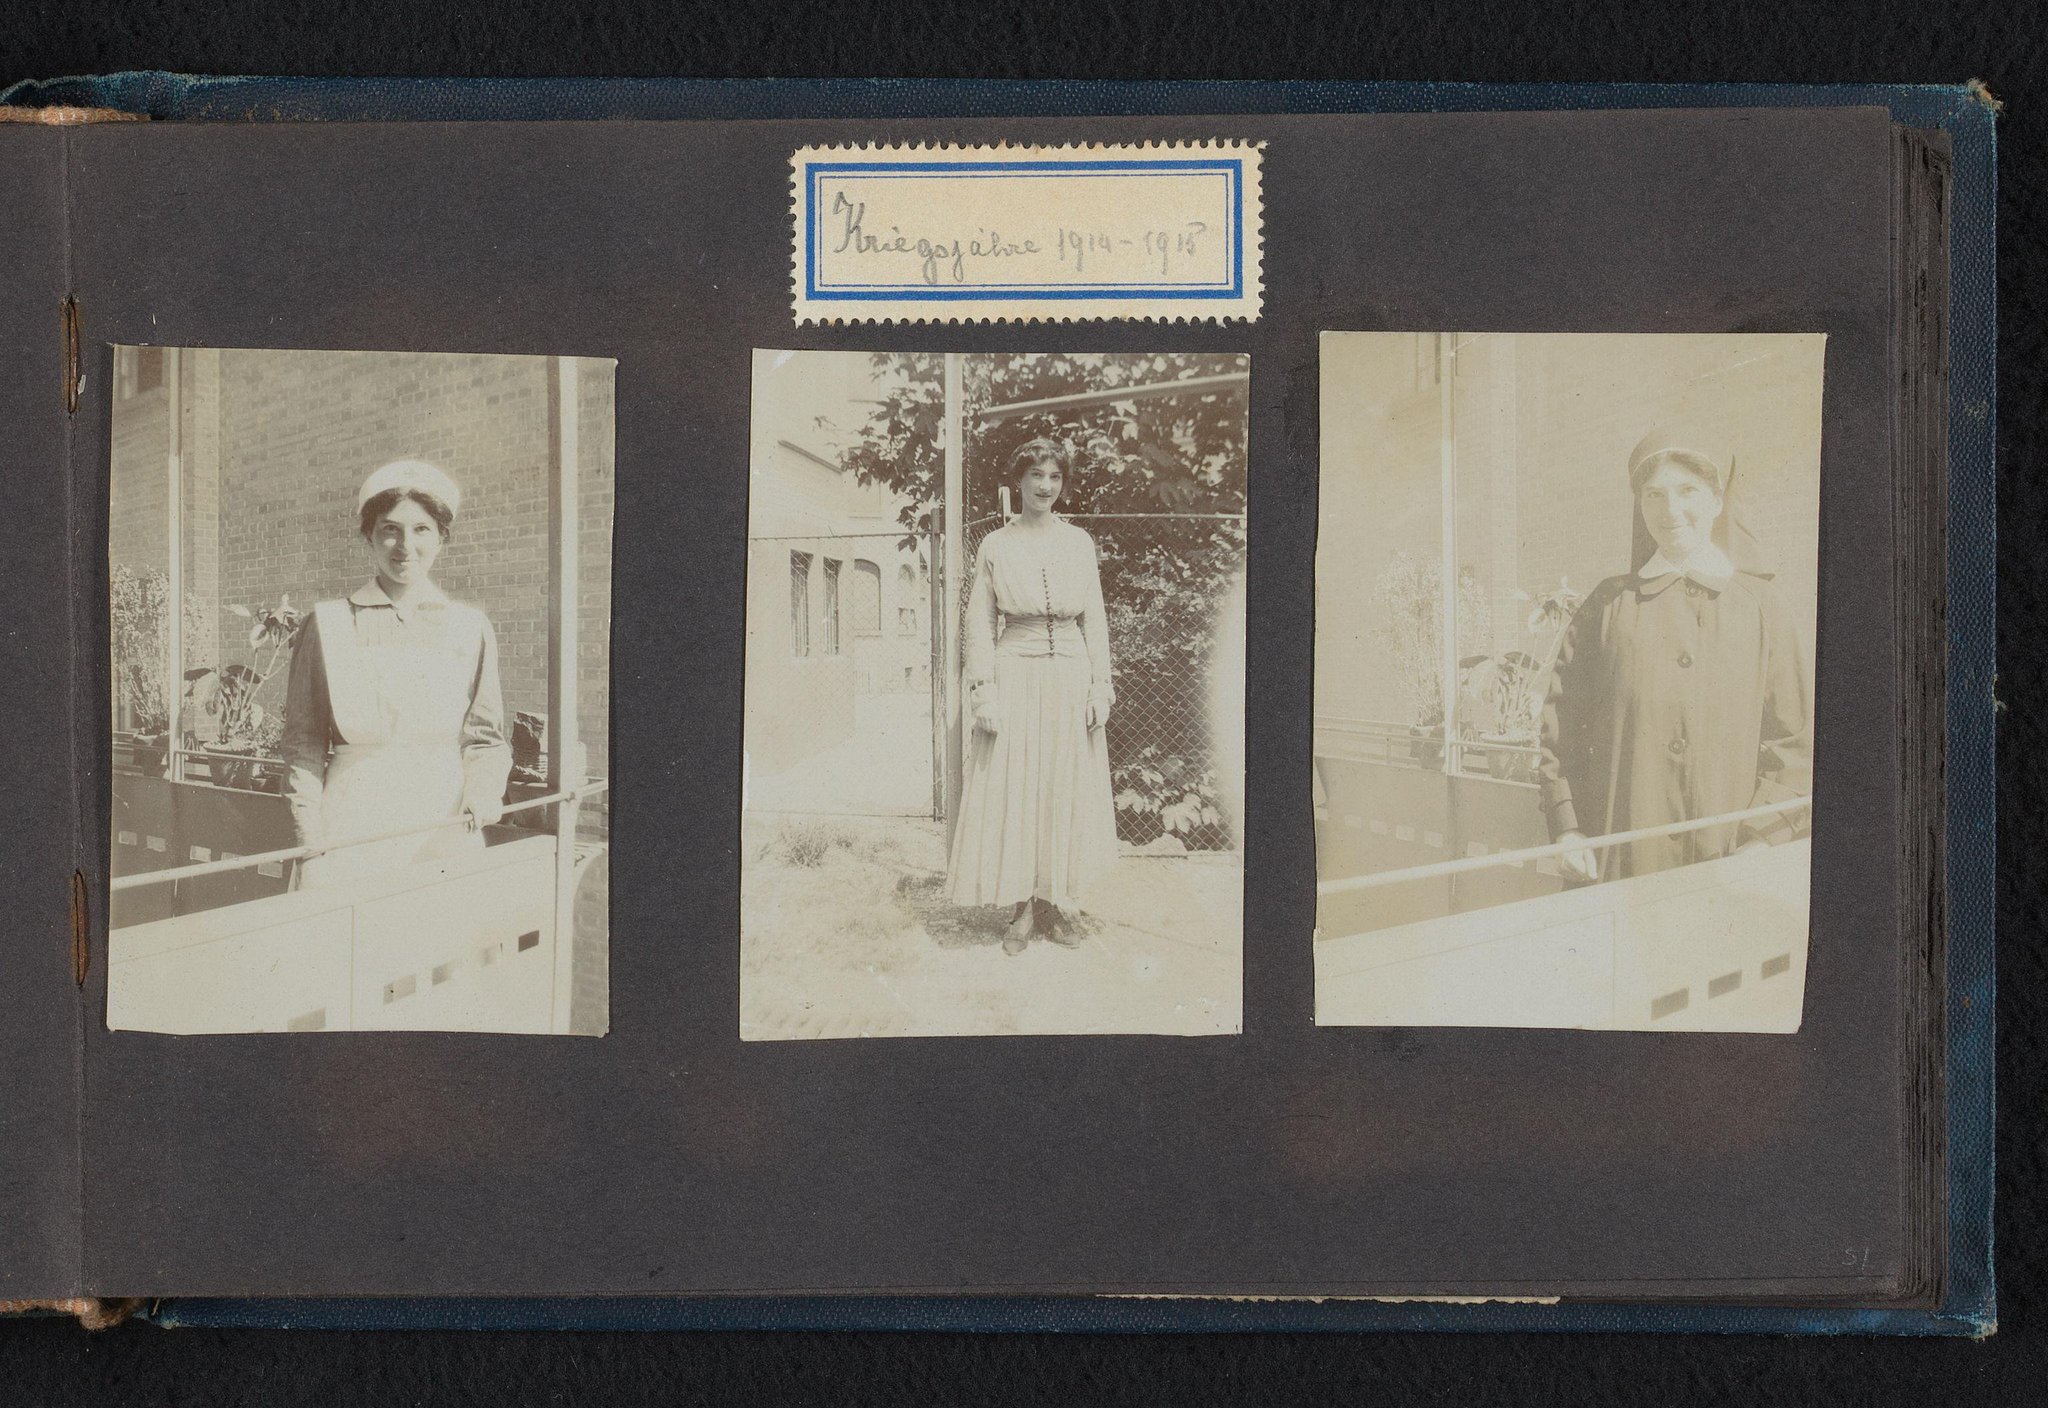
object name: album leaf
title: Vriendinnen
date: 1914-1915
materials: paper, photographic support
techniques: gelatin silver print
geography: germany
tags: else wachenheimer-moos, nurse ~ hospital, germany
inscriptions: inscription: ‘Kriegsjahre 1914-1915’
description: Albumblad met drie foto's van vriendinnen van Else, twee foto's in het uniform van een verpleegster. Onderdeel van het fotoalbum van Else Wachenheimer-Moos en haar broers Arthur en Willy Moos en anderen in de periode 1913-1918.